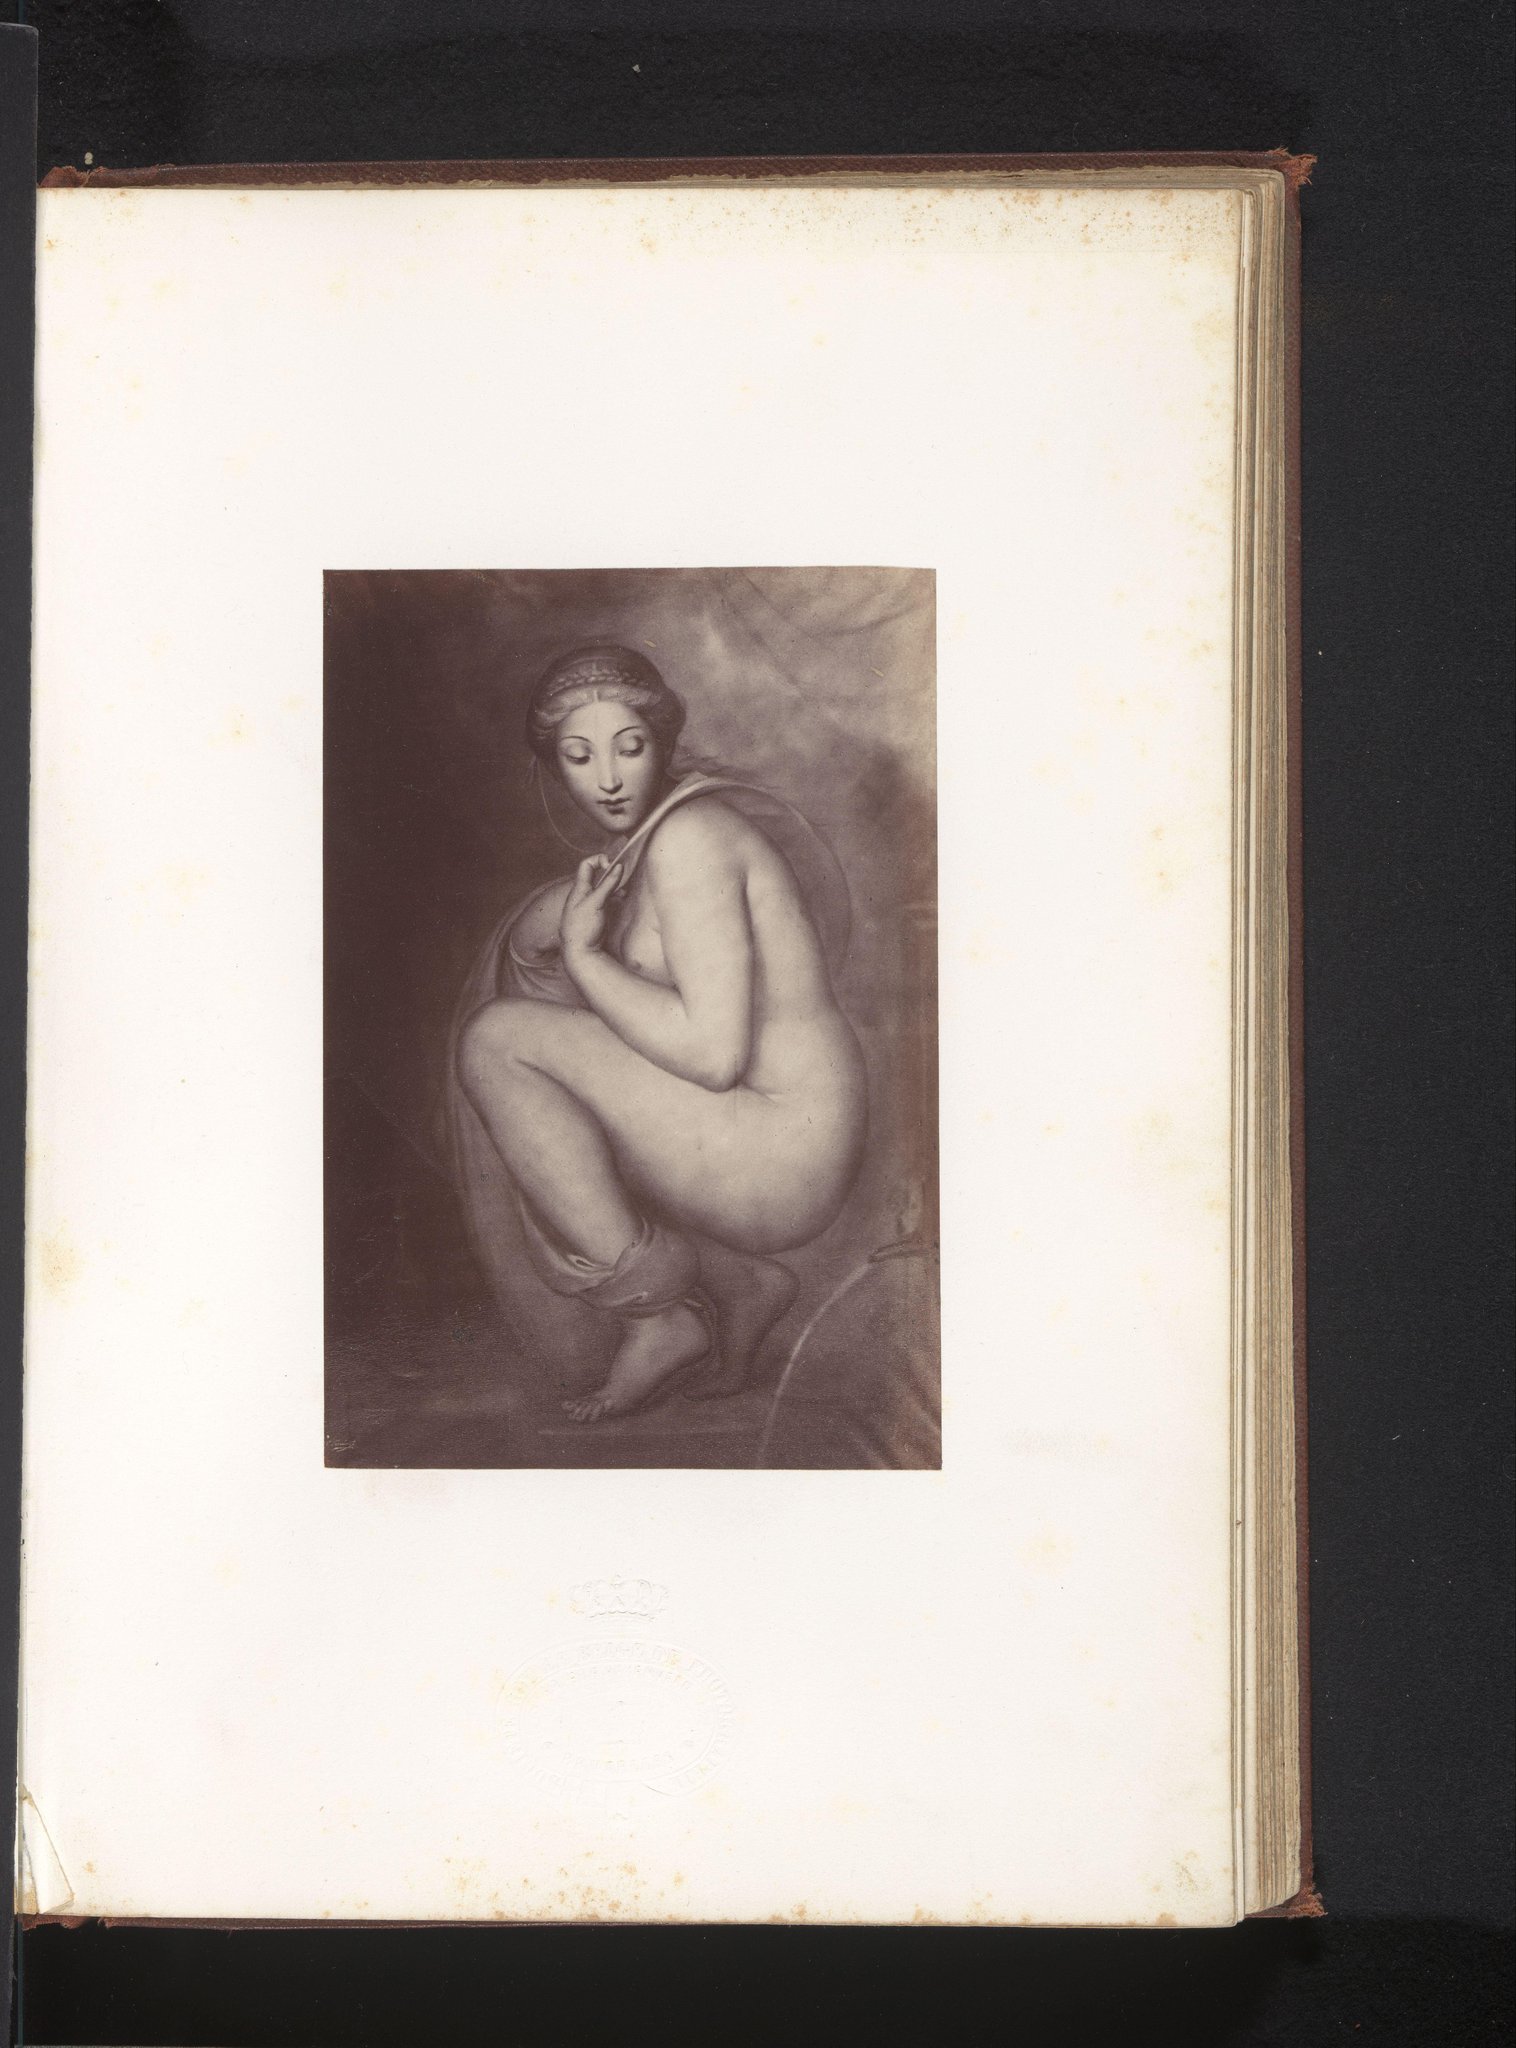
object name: reproduction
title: Fotoreproductie van Meisje voor het bad door Antoine Wiertz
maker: edmond fierlants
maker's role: fotograaf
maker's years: 1819-1869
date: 1863-1868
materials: photographic support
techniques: albumen print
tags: woman (showing herself) undressed, quasi-nude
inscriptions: check stamp: ‘SOCIÉTÉ ROYALE BELGE DE PHOTOGRAPHIE/ 69, RUE KEYENVELD/ BRUXELLES’